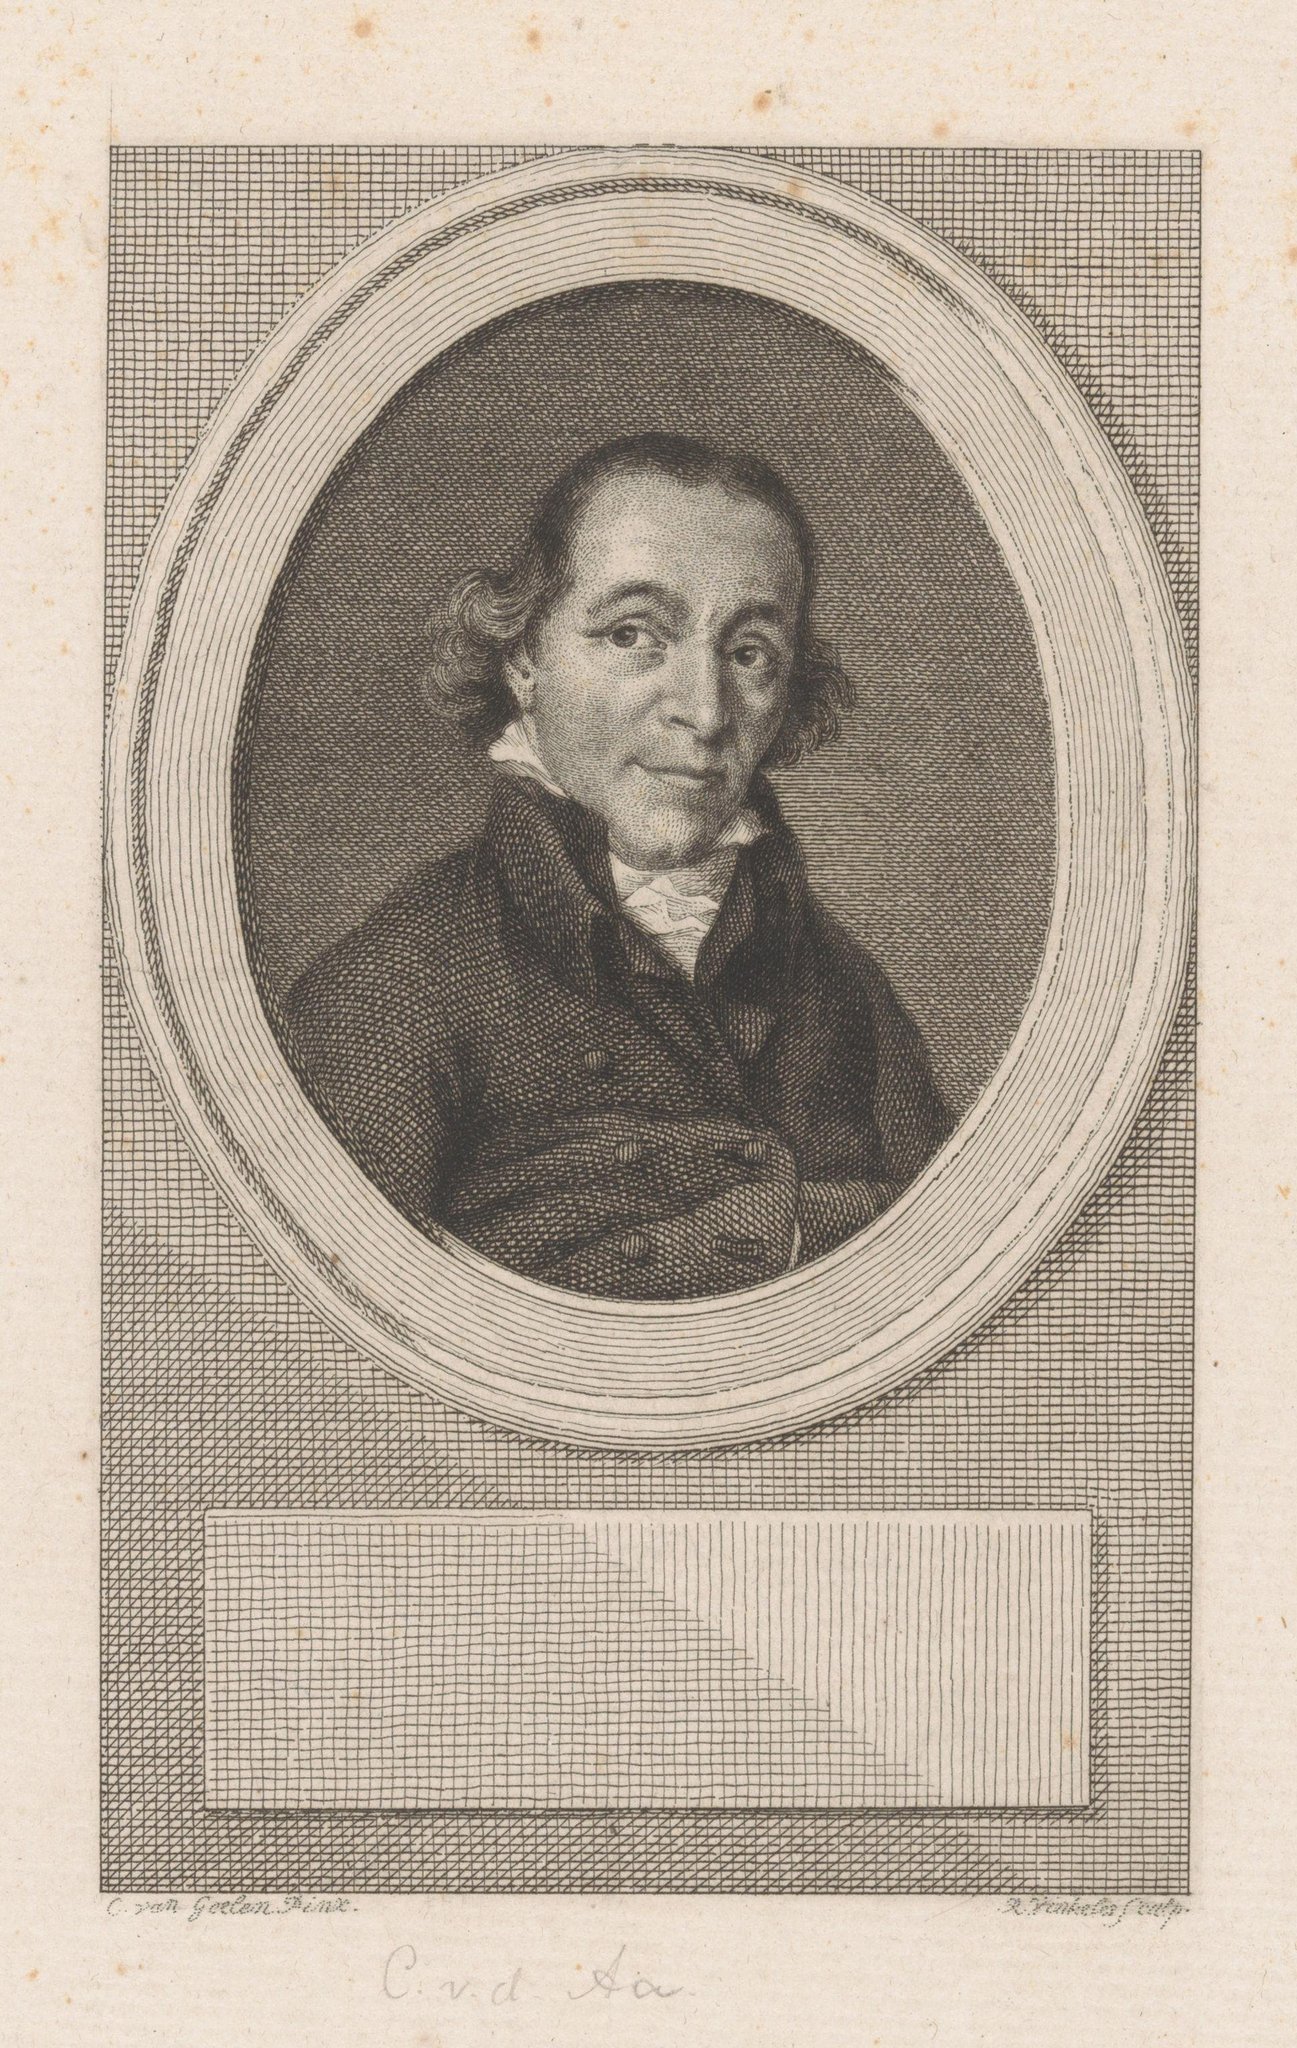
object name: print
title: Portret van Cornelis van der Aa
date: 1769-1816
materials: paper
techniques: engraving, etching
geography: amsterdam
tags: publisher, cornelis van der aa, portrait of a writer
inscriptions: collector's mark: Lugt 964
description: Portret van Cornelis van der Aa in een ovale omlijsting. Daaronder een leeg kader.